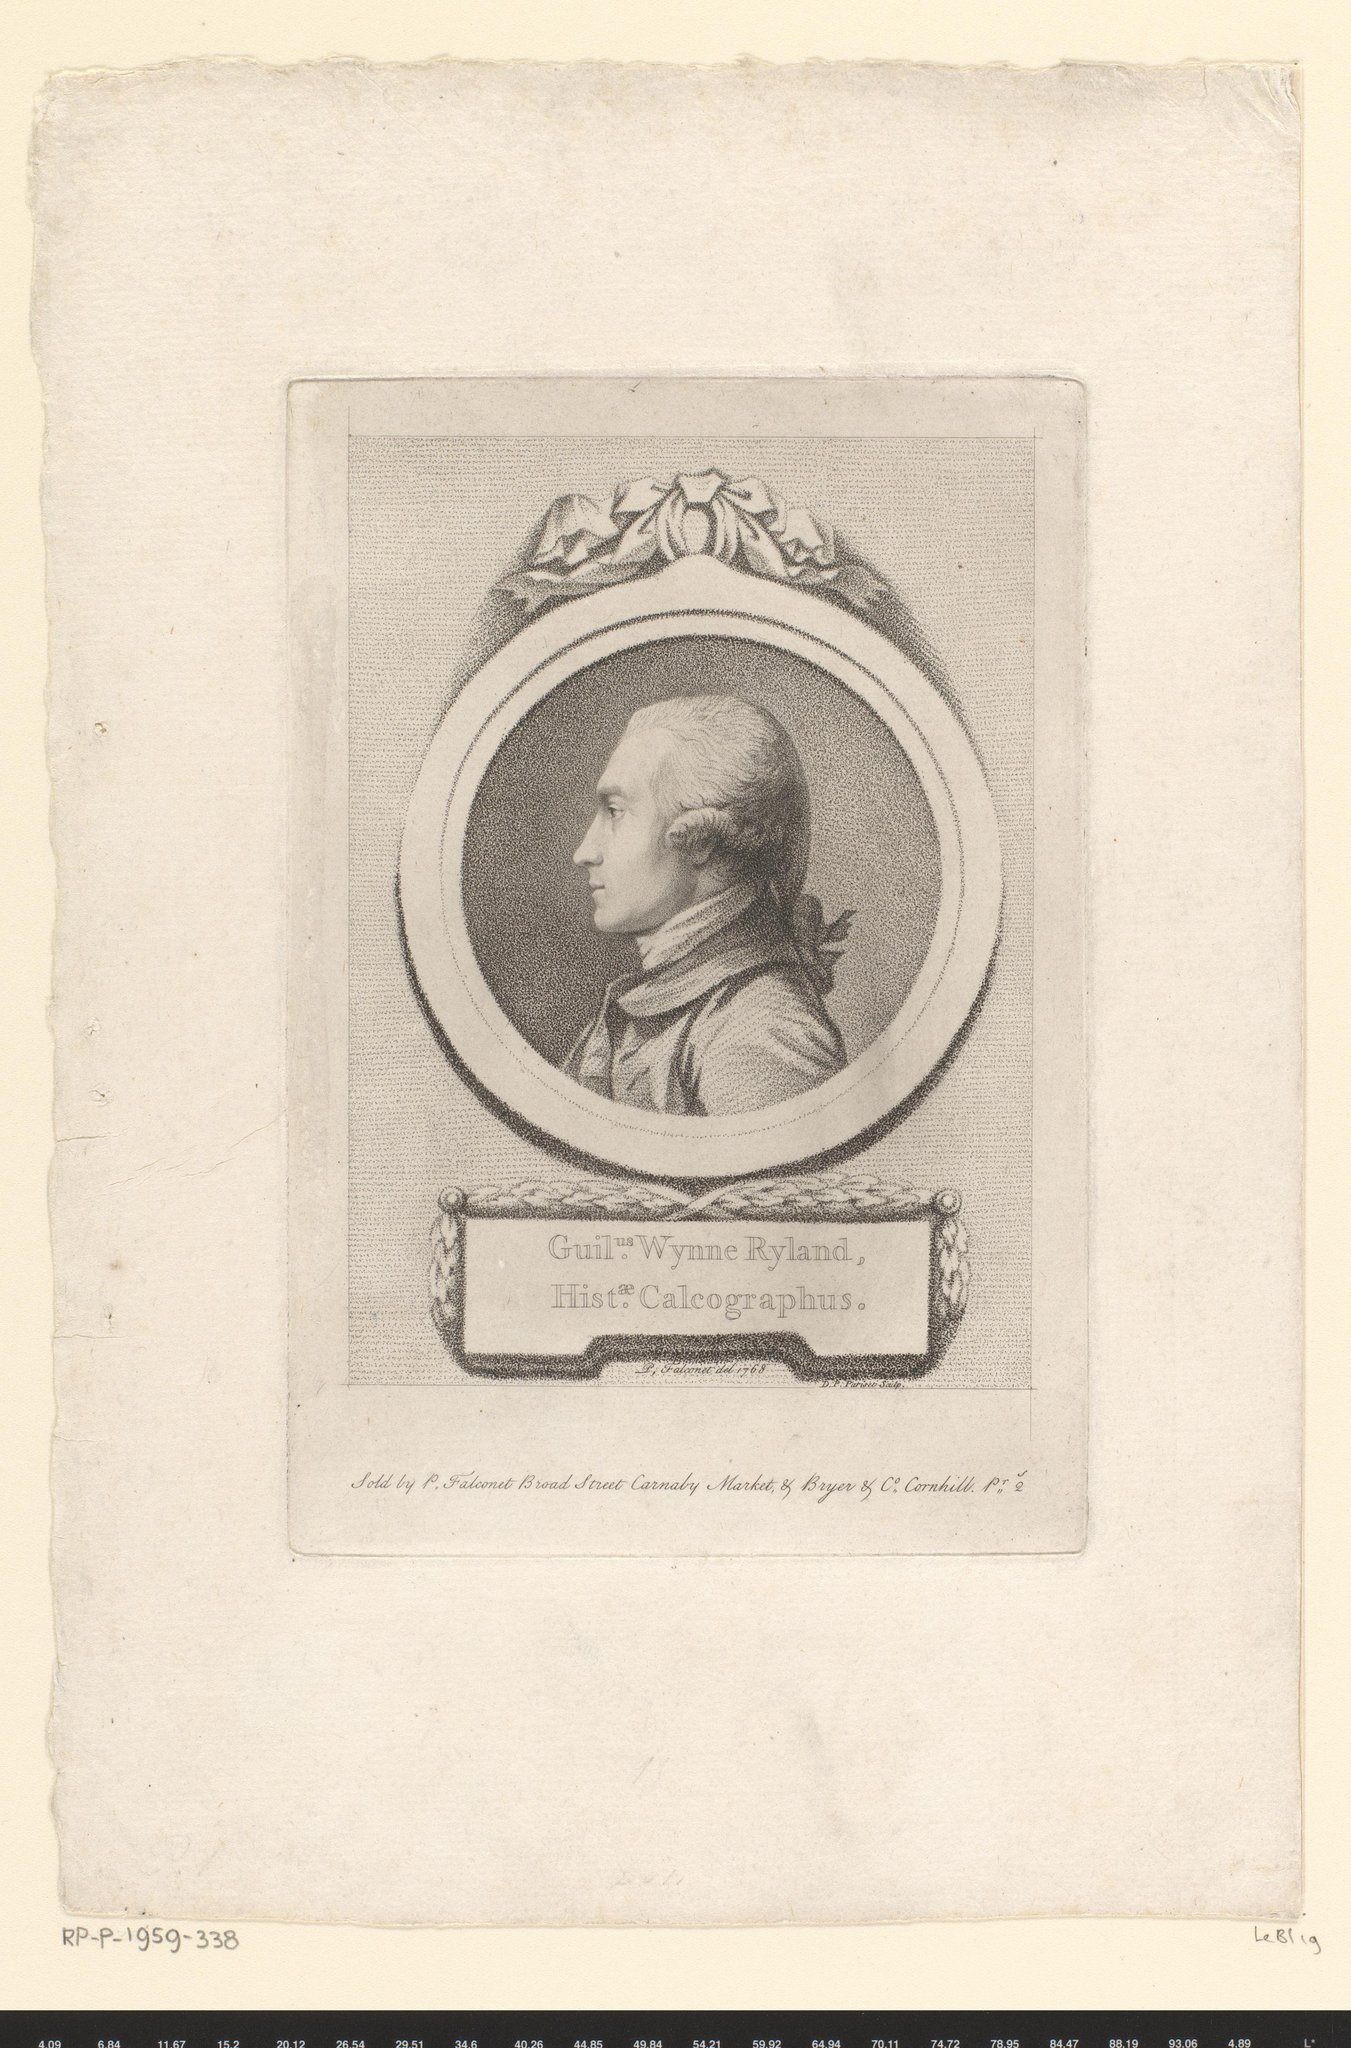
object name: print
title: Guil.us Wynne Ryland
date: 1768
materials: paper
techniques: etching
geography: paris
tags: london, print maker, historical persons, portrait, self-portrait of graphic artist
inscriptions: collector's mark: Lugt 2228, collector's mark: Lugt 4347, collector's mark: Lugt 2760